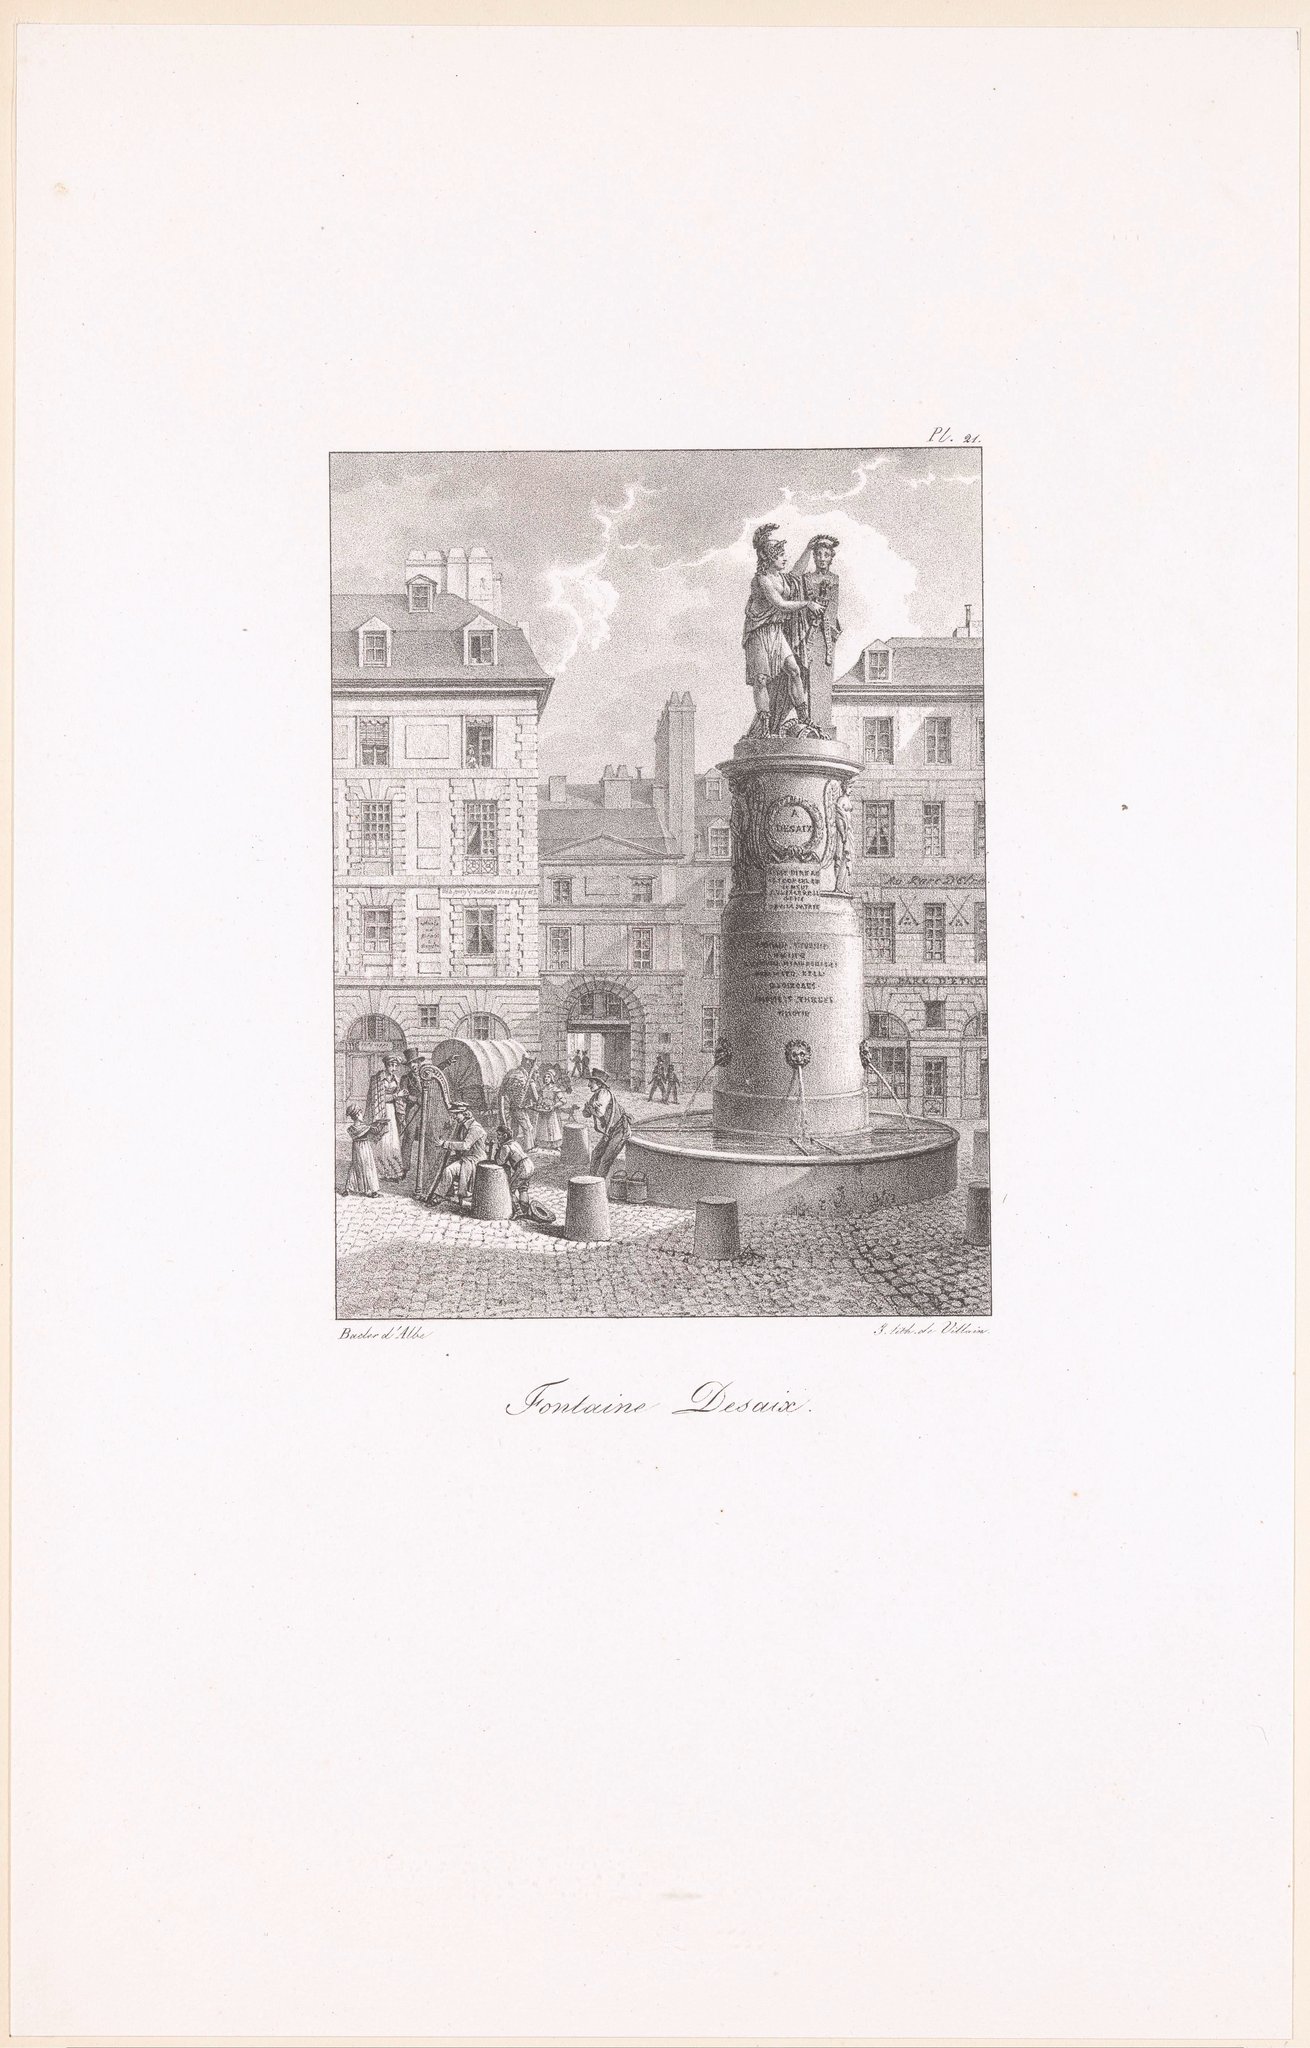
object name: print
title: Fontaine Desaix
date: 1822-1824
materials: paper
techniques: lithograph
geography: paris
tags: ornamental fountain, harp - cc - out of doors, village square, place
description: De fontein, ontworpen door Charles Percier, stond op de Place Desaix (tegenwoordig Place Dauphine) in Parijs. Hij werd gedemonteerd in 1874 en grotendeels verplaatst naar Riom in 1906.